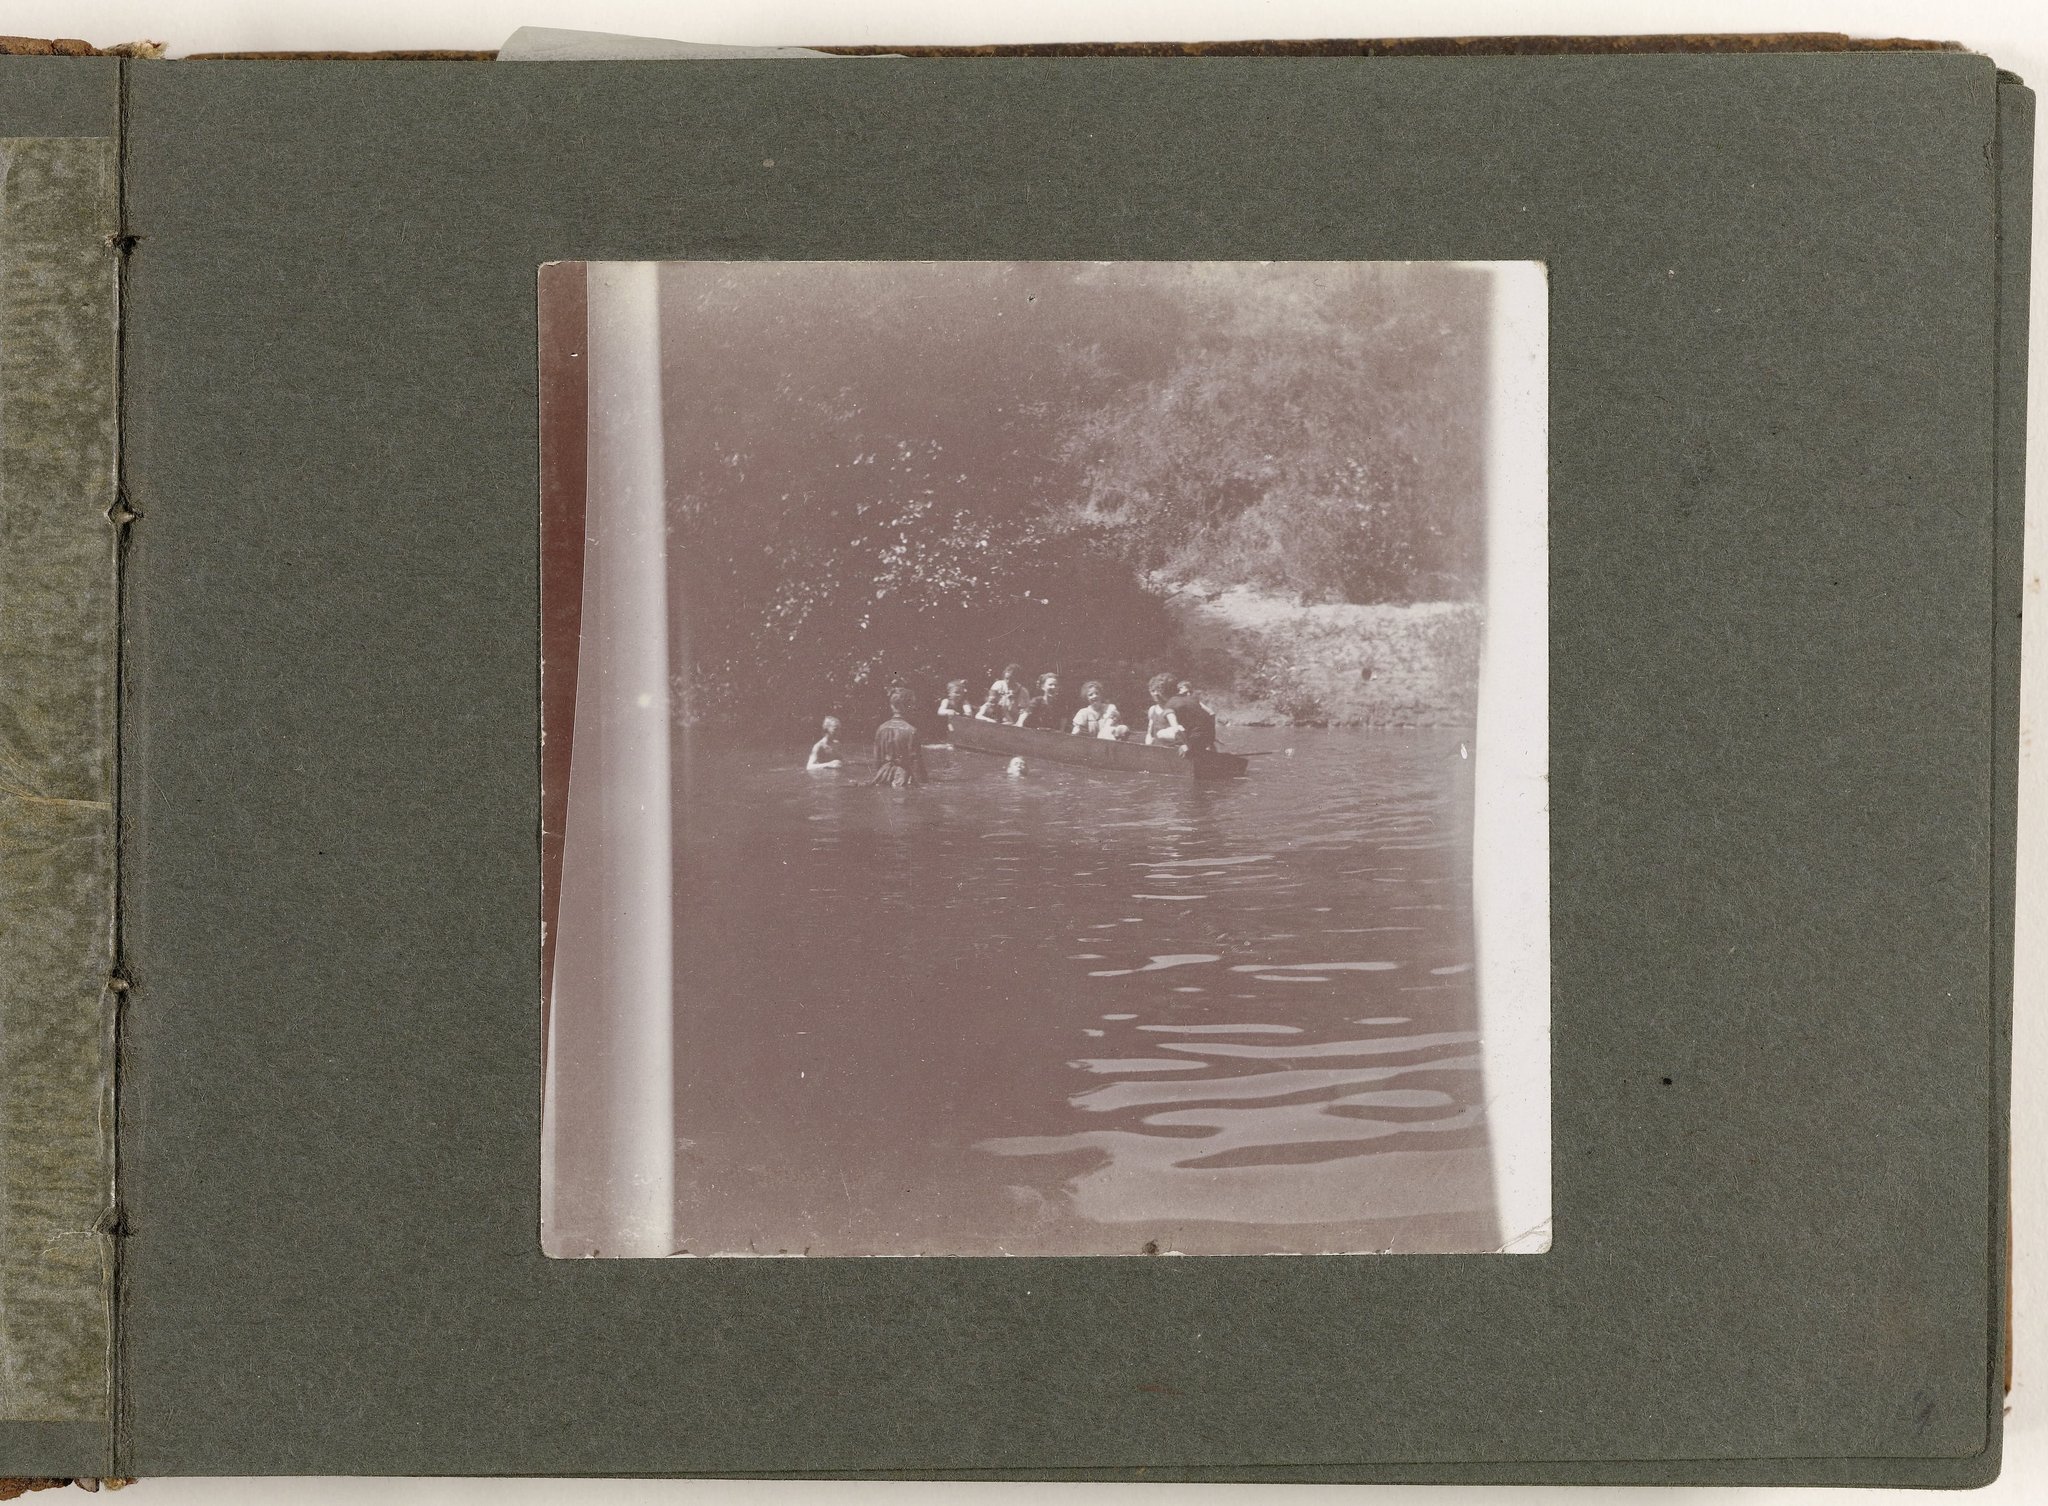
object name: album leaf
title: Gezelschap zwemmend en in een roeiboot, Cupsuptic Lake, Maine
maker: Anonymous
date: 1900-1920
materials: paper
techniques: gelatin silver print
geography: maine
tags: rowing-boat, canoe, etc., swimming (movement in water)